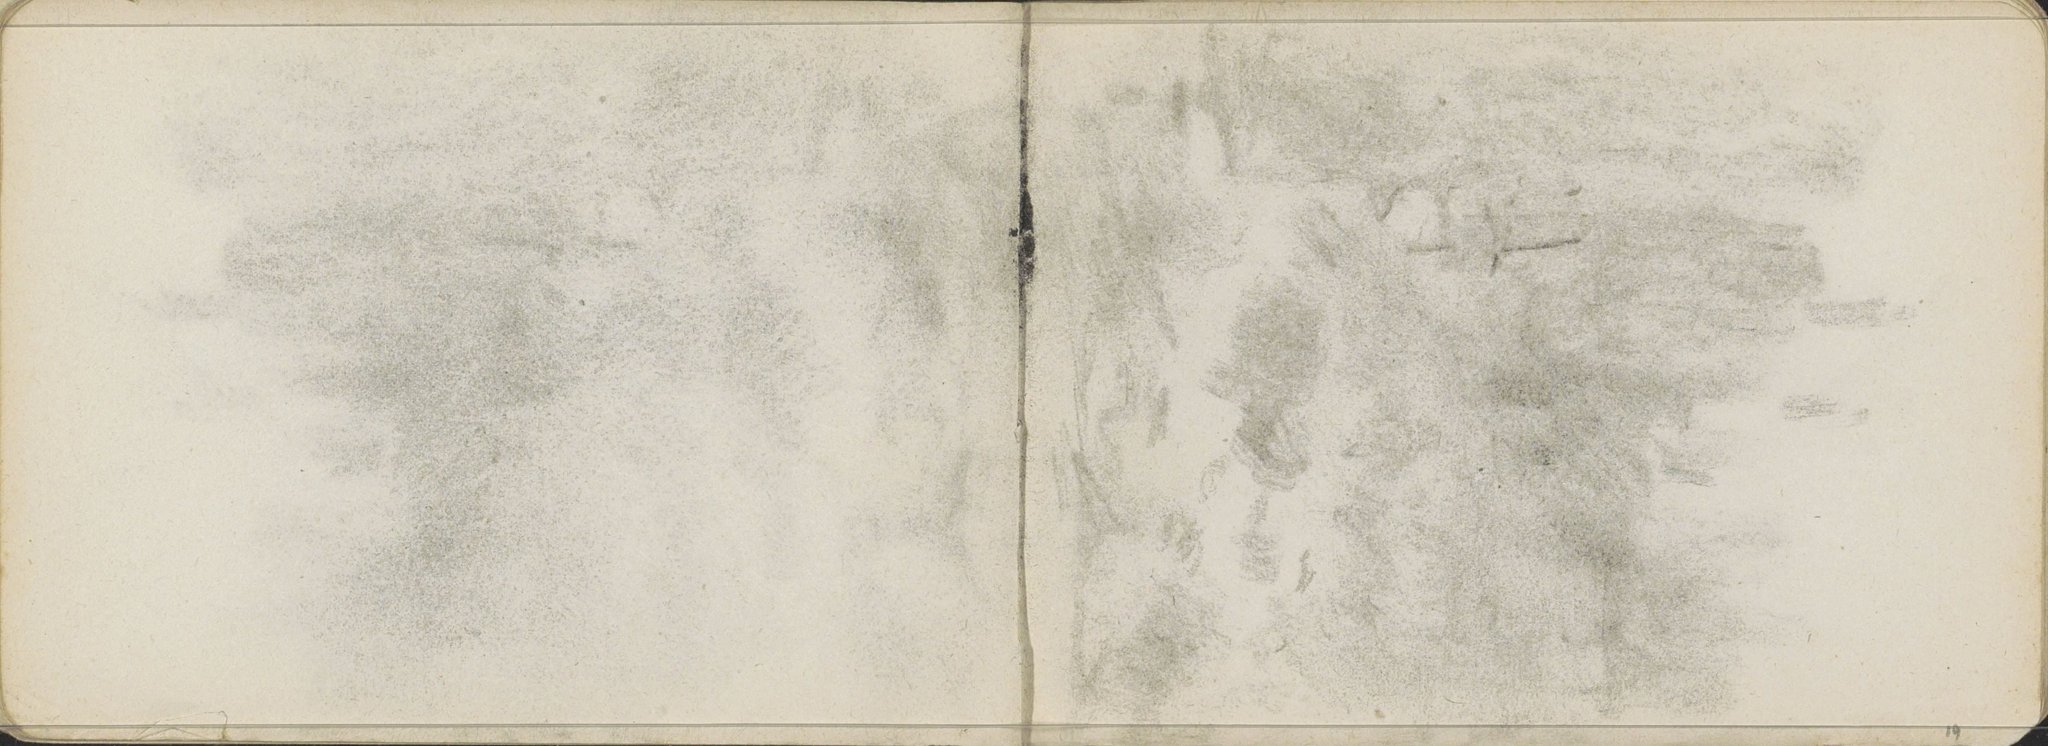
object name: sketchbook leaf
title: Studie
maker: willem cornelis rip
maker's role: draughtsman, painter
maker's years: 1856-1922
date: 1905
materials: chalk, paper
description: Blad 18 verso en 19 recto uit een schetsboek met 42 bladen.